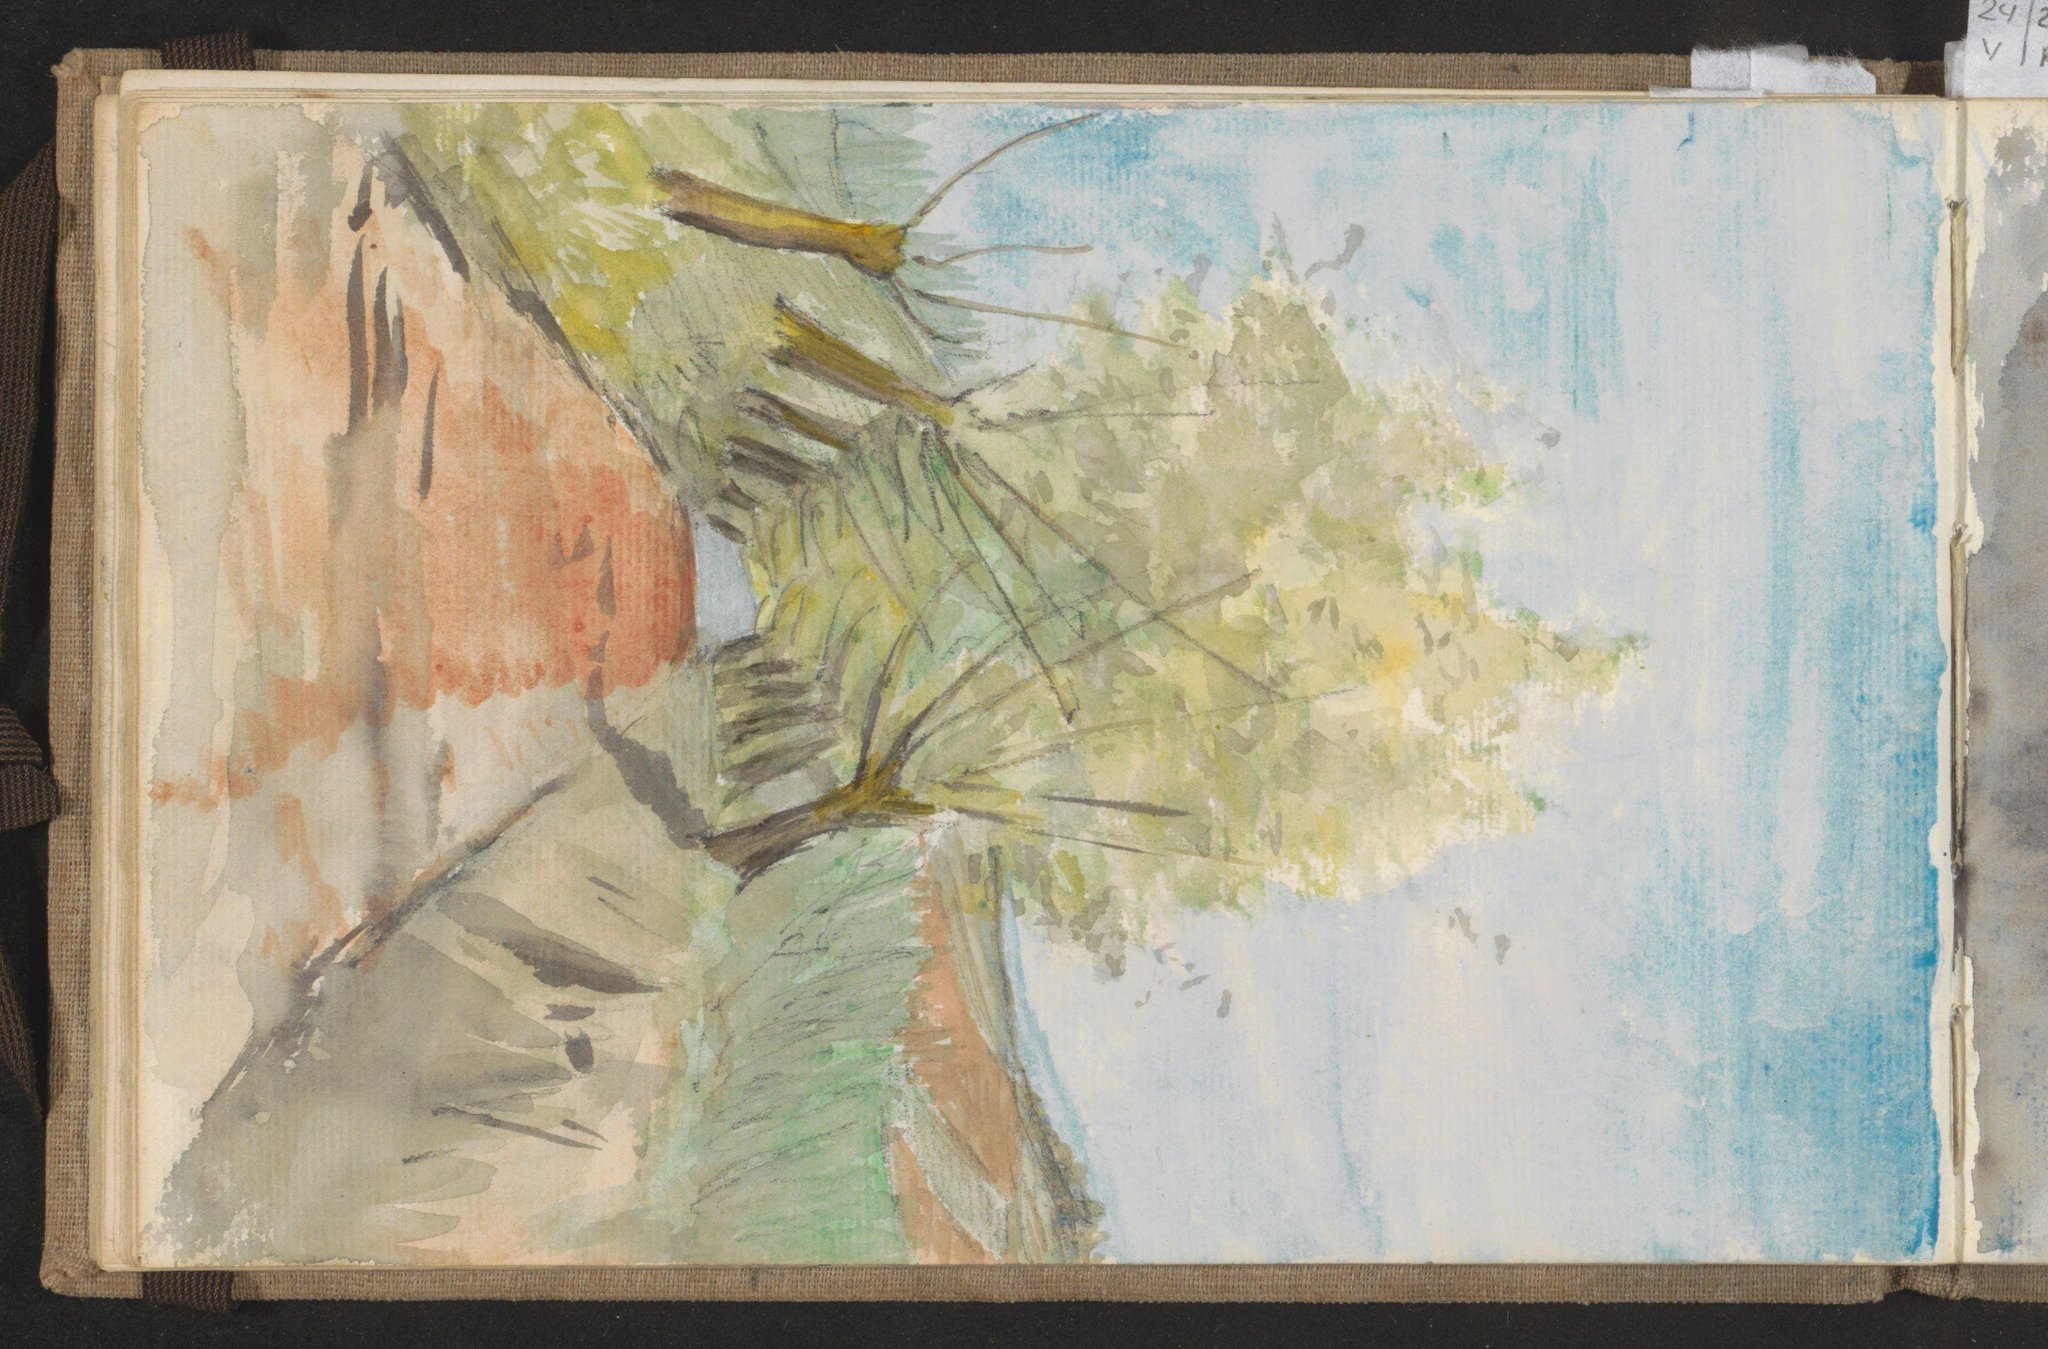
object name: sketchbook leaf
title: Heuvellandschap met bomenlaan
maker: jonkheer johannes ludovicus paulus bosch van drakestein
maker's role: draughtsman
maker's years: 1865-1929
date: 1896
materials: paper, pencil, watercolor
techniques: brush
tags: low hill country, trees, road, path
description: Blad 19 verso uit een schetsboek met 58 bladen.